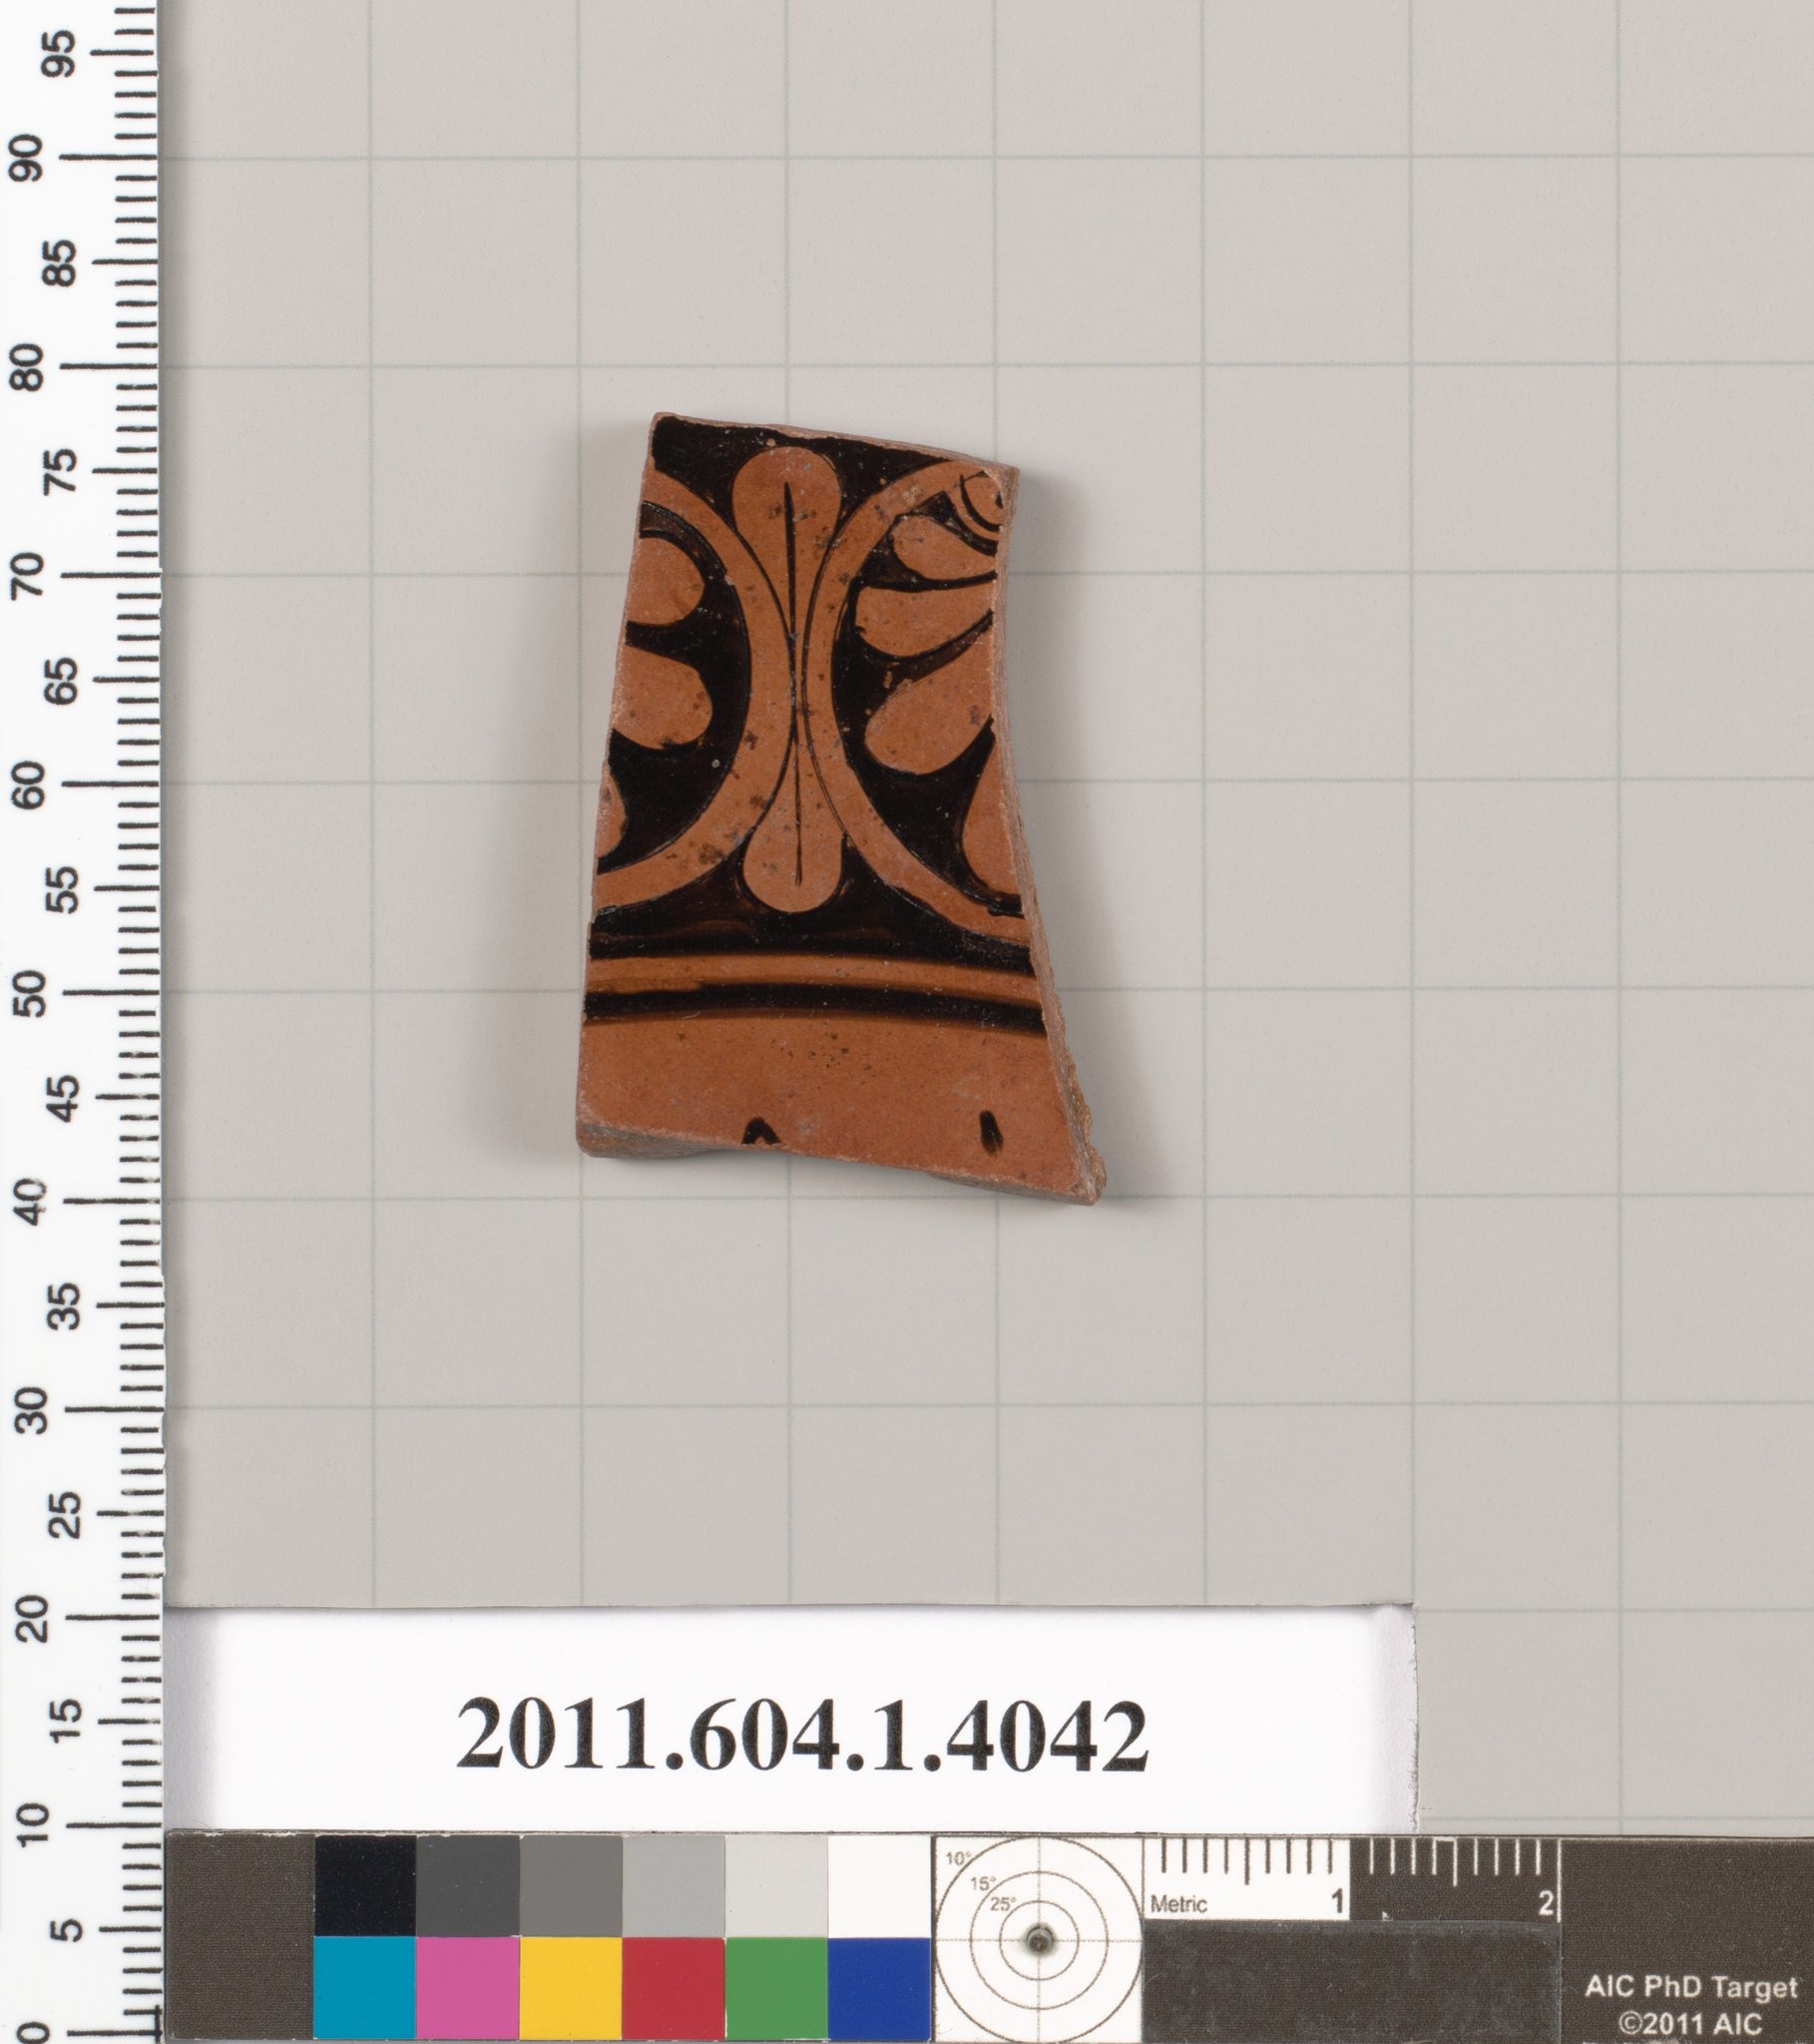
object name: kylix fragment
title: Terracotta fragment of a bilingual? kylix (drinking cup)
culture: greek, attic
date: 534-468 BCE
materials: terracotta